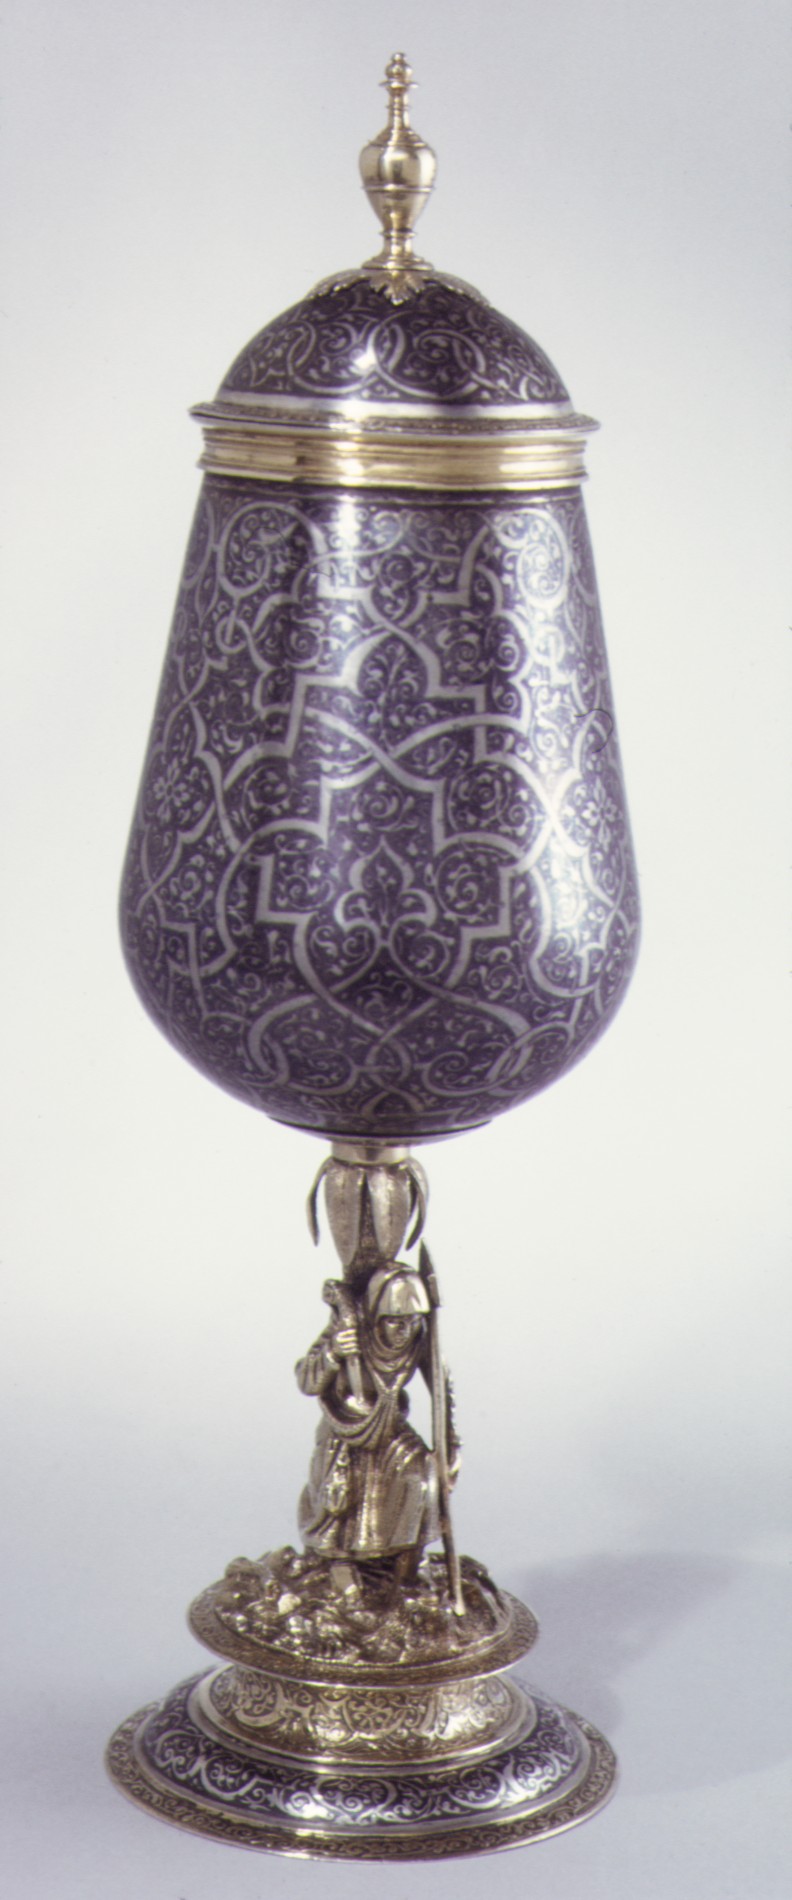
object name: cup with cover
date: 1801-1900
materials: niello, silver gilt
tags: human figures